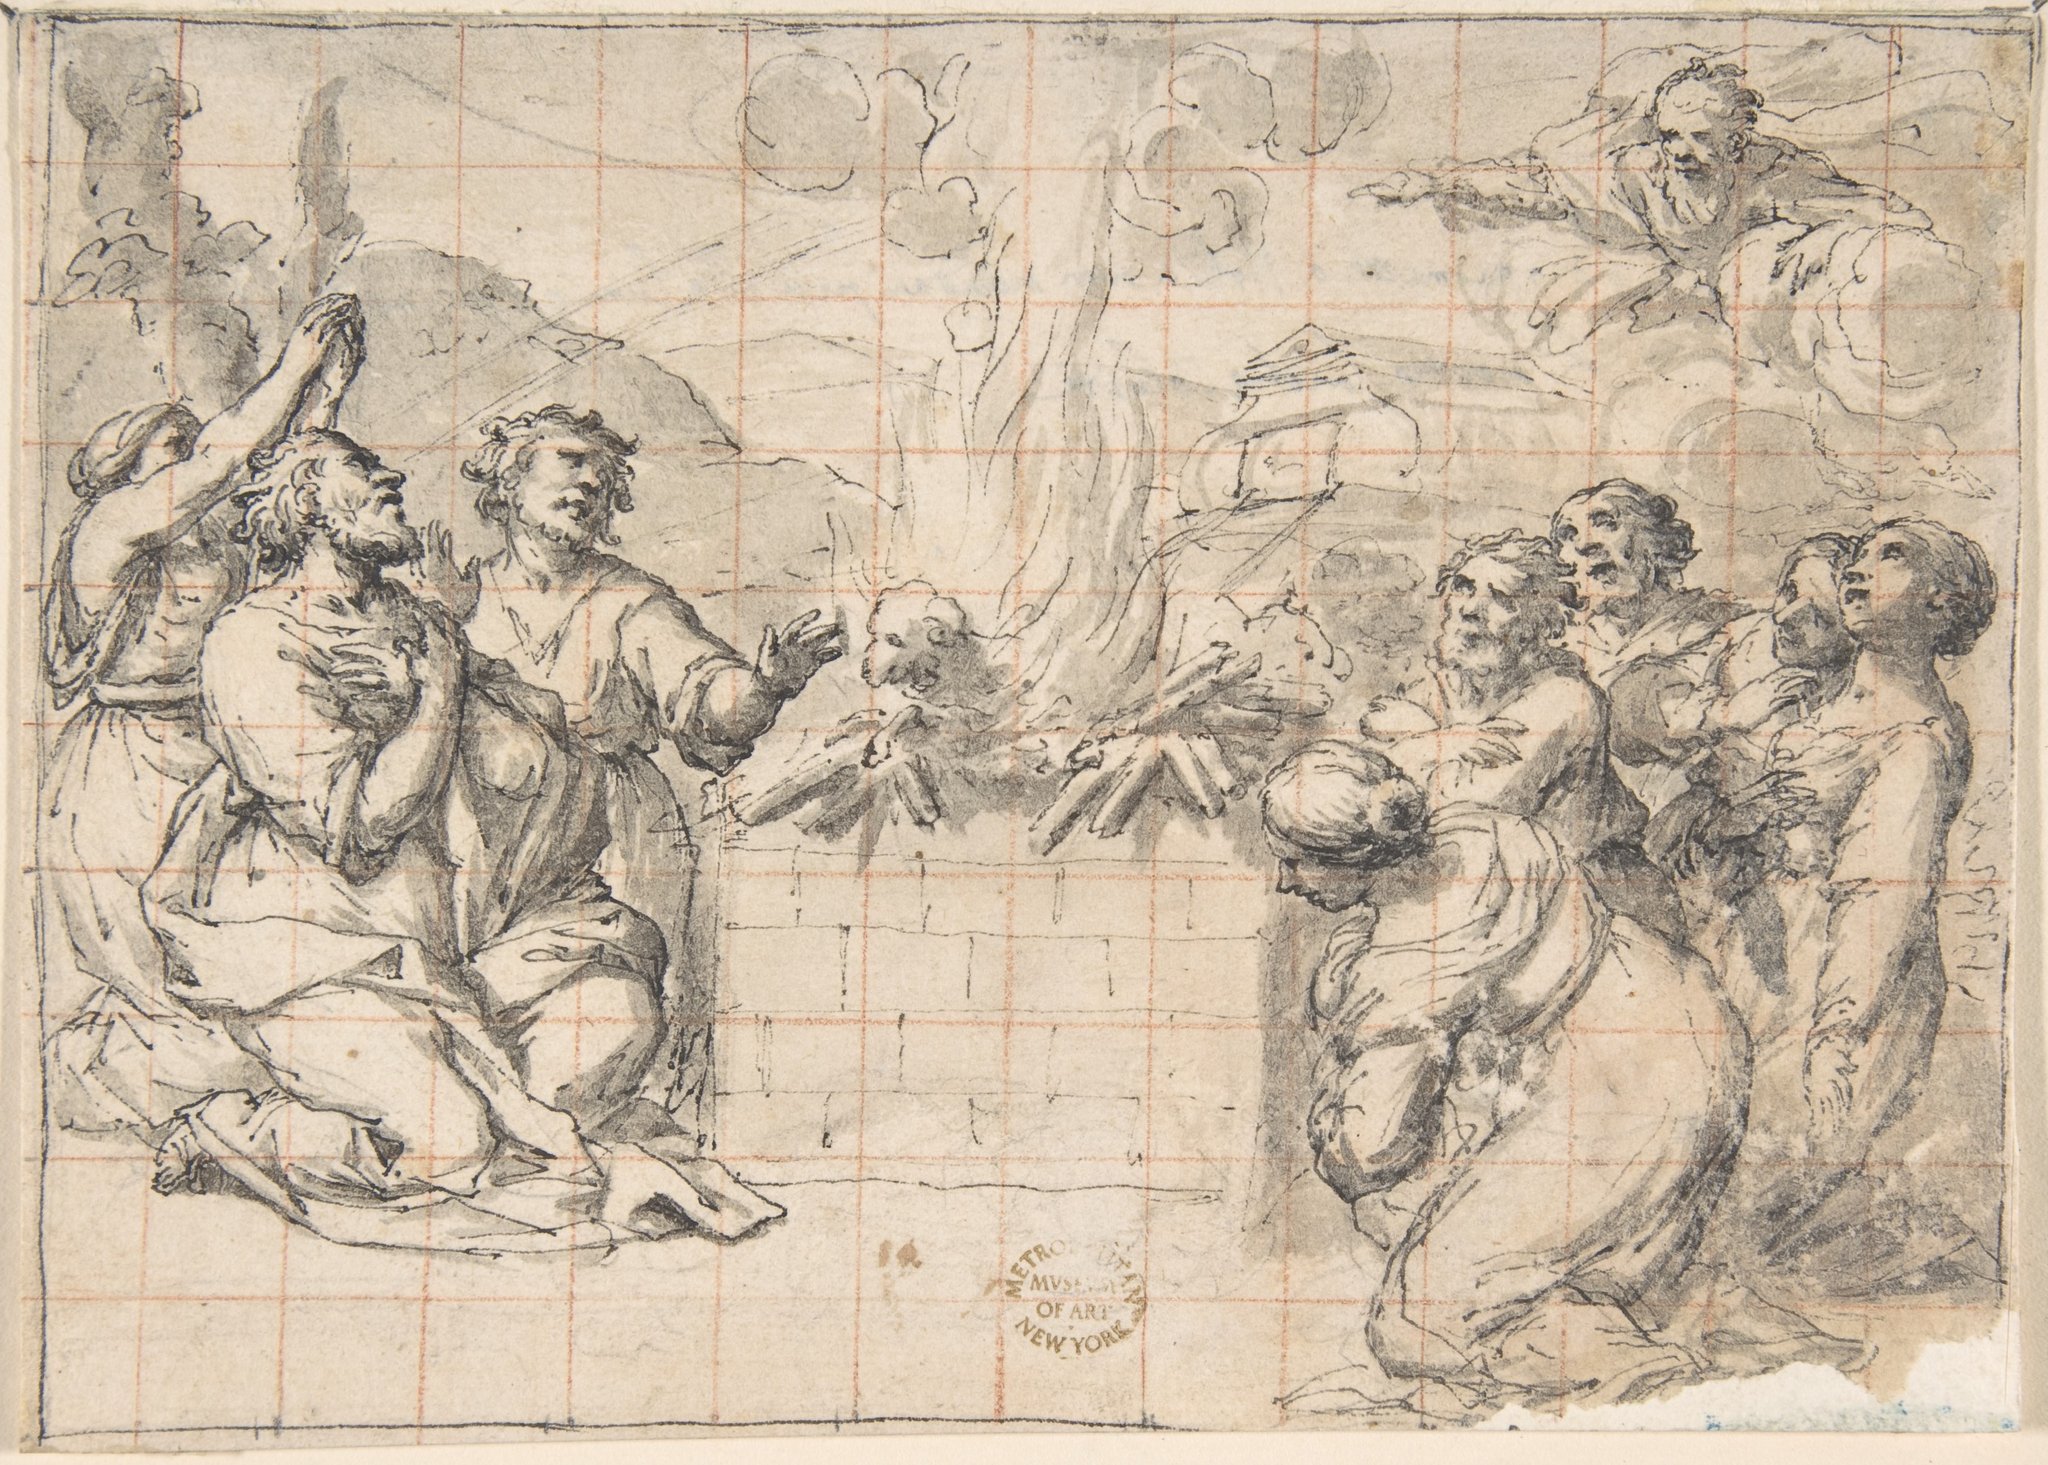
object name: drawing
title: The Sacrifice of Noah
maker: lazzaro baldi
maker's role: artist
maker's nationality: italian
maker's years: 1622-1703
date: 1642-1703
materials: chalk, ink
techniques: brush, pen, drawing, wash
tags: men,women